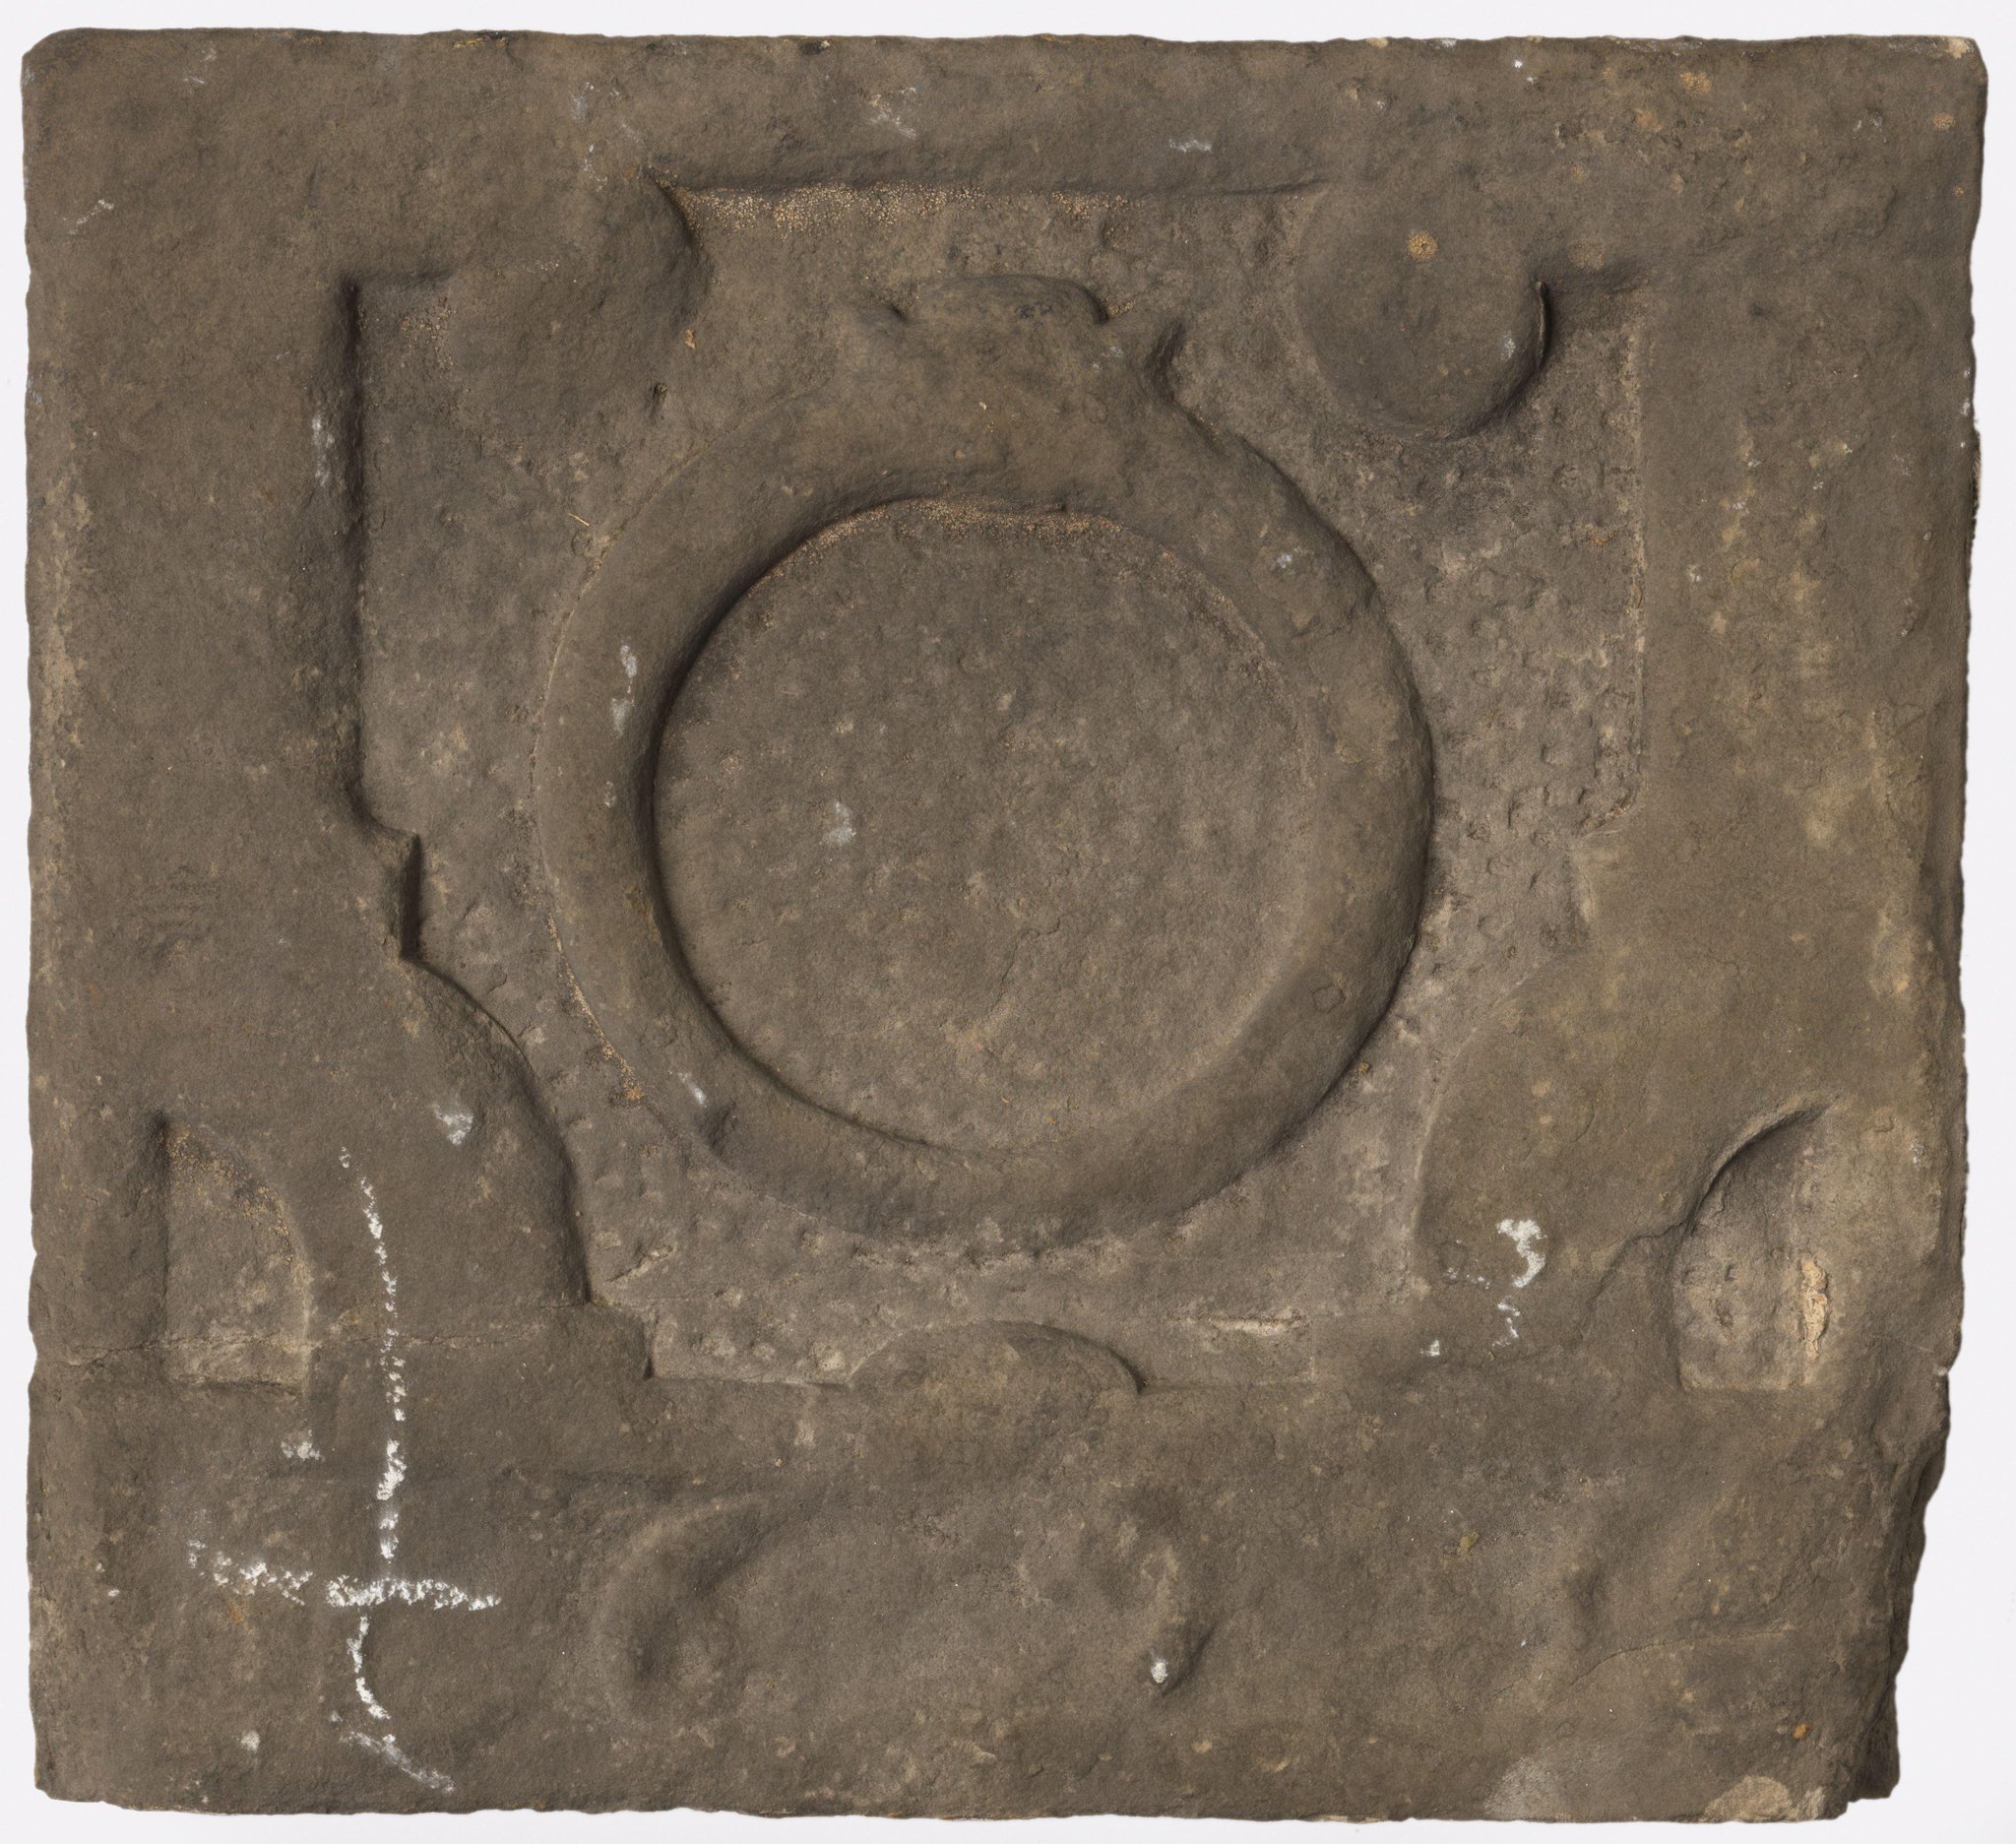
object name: gable stone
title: Gevelsteen met ring binnen omlijsting. Jaartal 16..(?).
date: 1600-1699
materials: stone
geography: netherlands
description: Vierkante steen waarop een omlijstig waarbinnen een ring. In de onderrand van de omlijsting een slecht leesbaar jaartal 16..(?).